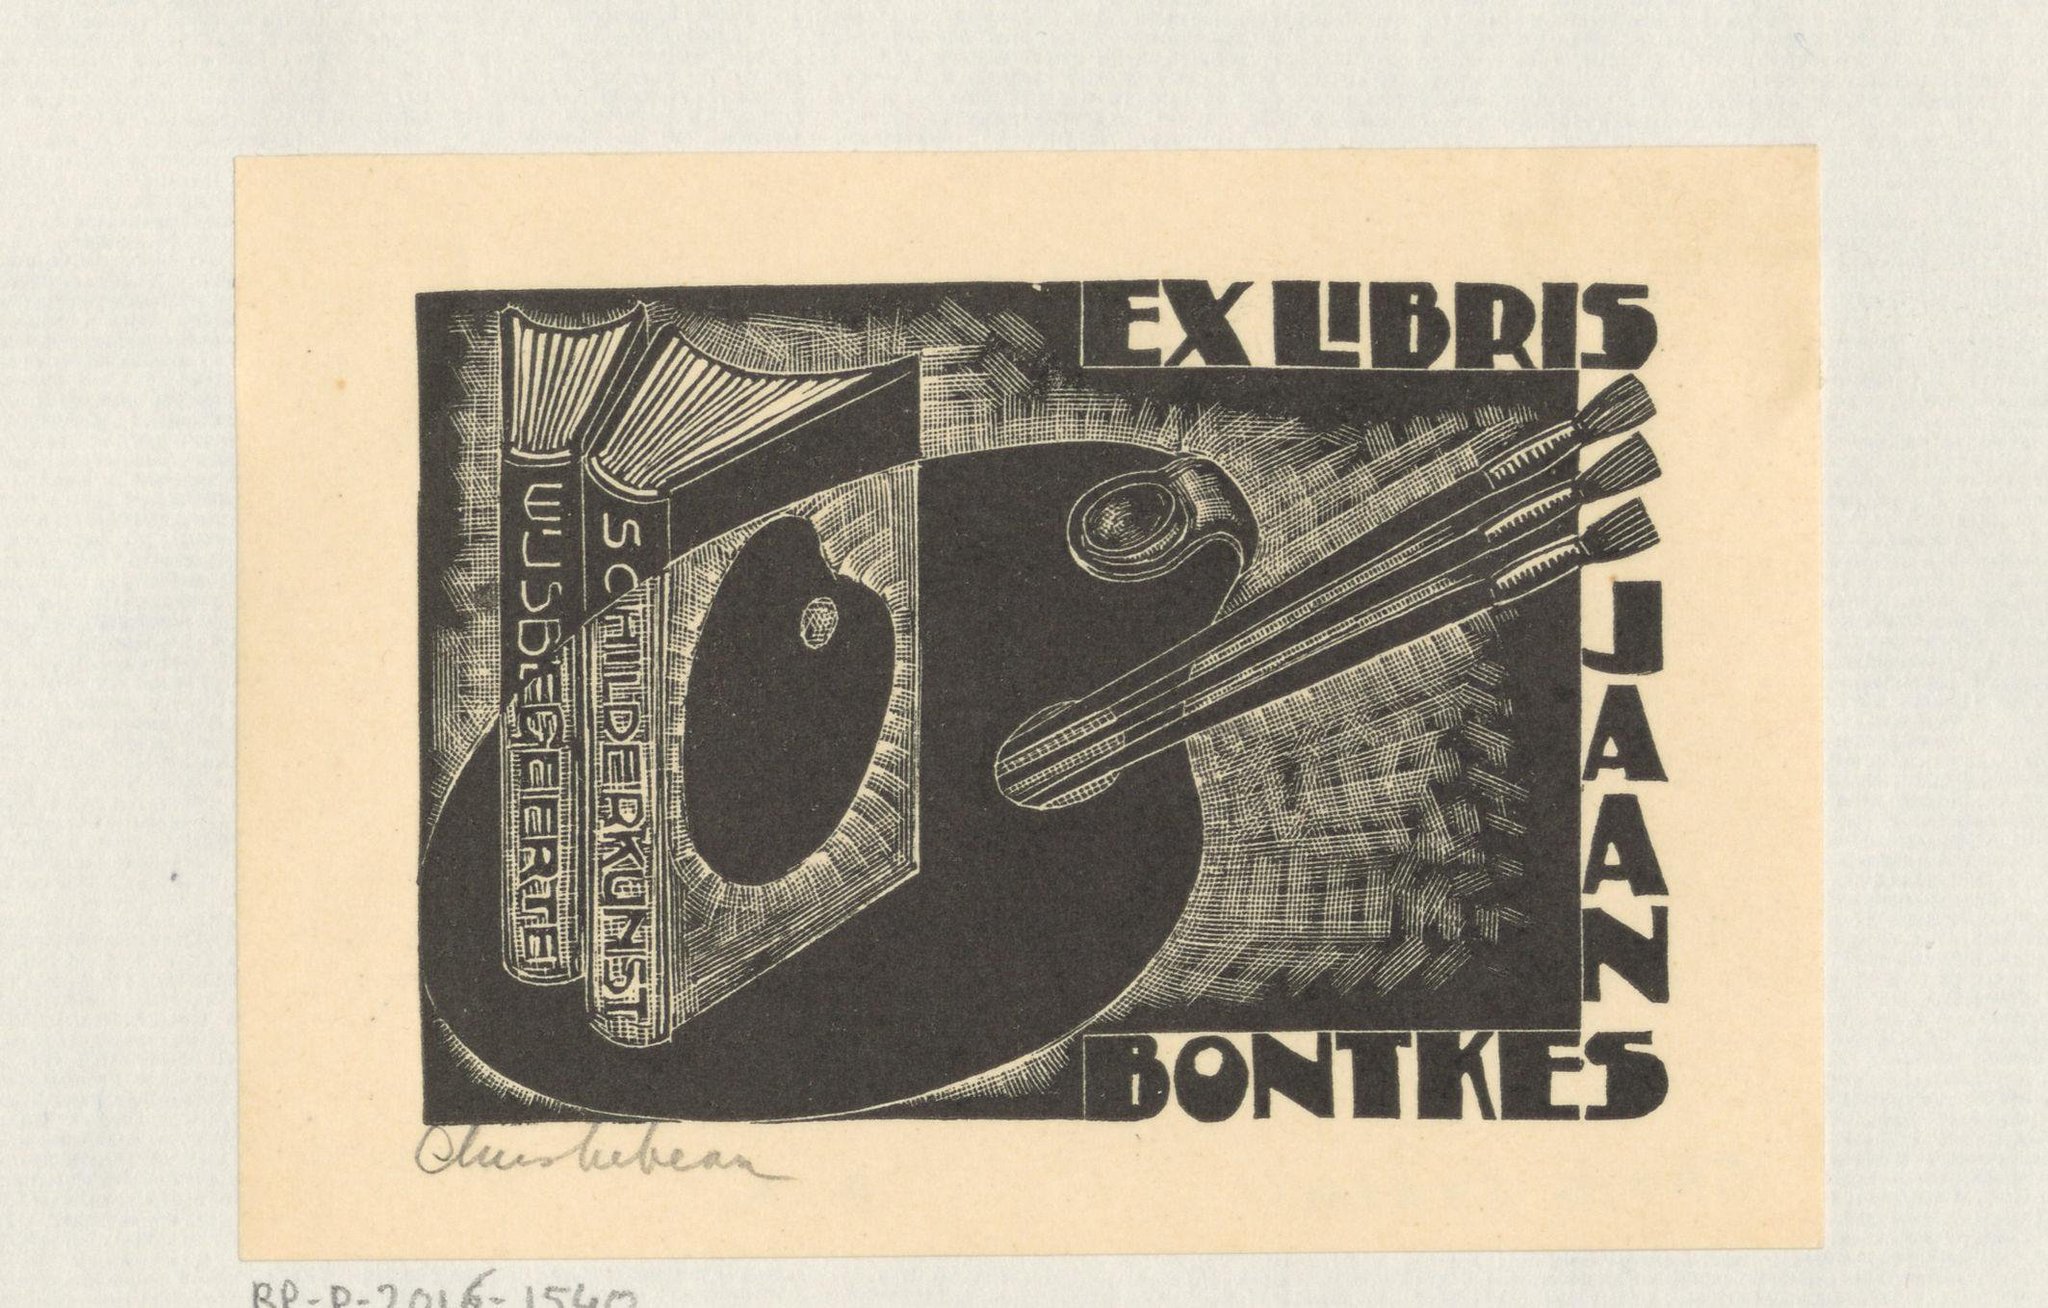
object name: bookplate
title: Ex libris van Jaan Bontkes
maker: chris lebeau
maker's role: draughtsman, print maker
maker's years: 1878-1945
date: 1932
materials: paper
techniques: woodcut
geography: netherlands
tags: jantjen bontkes, tools, implements of painter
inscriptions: signature: ‘Chris Lebeau’